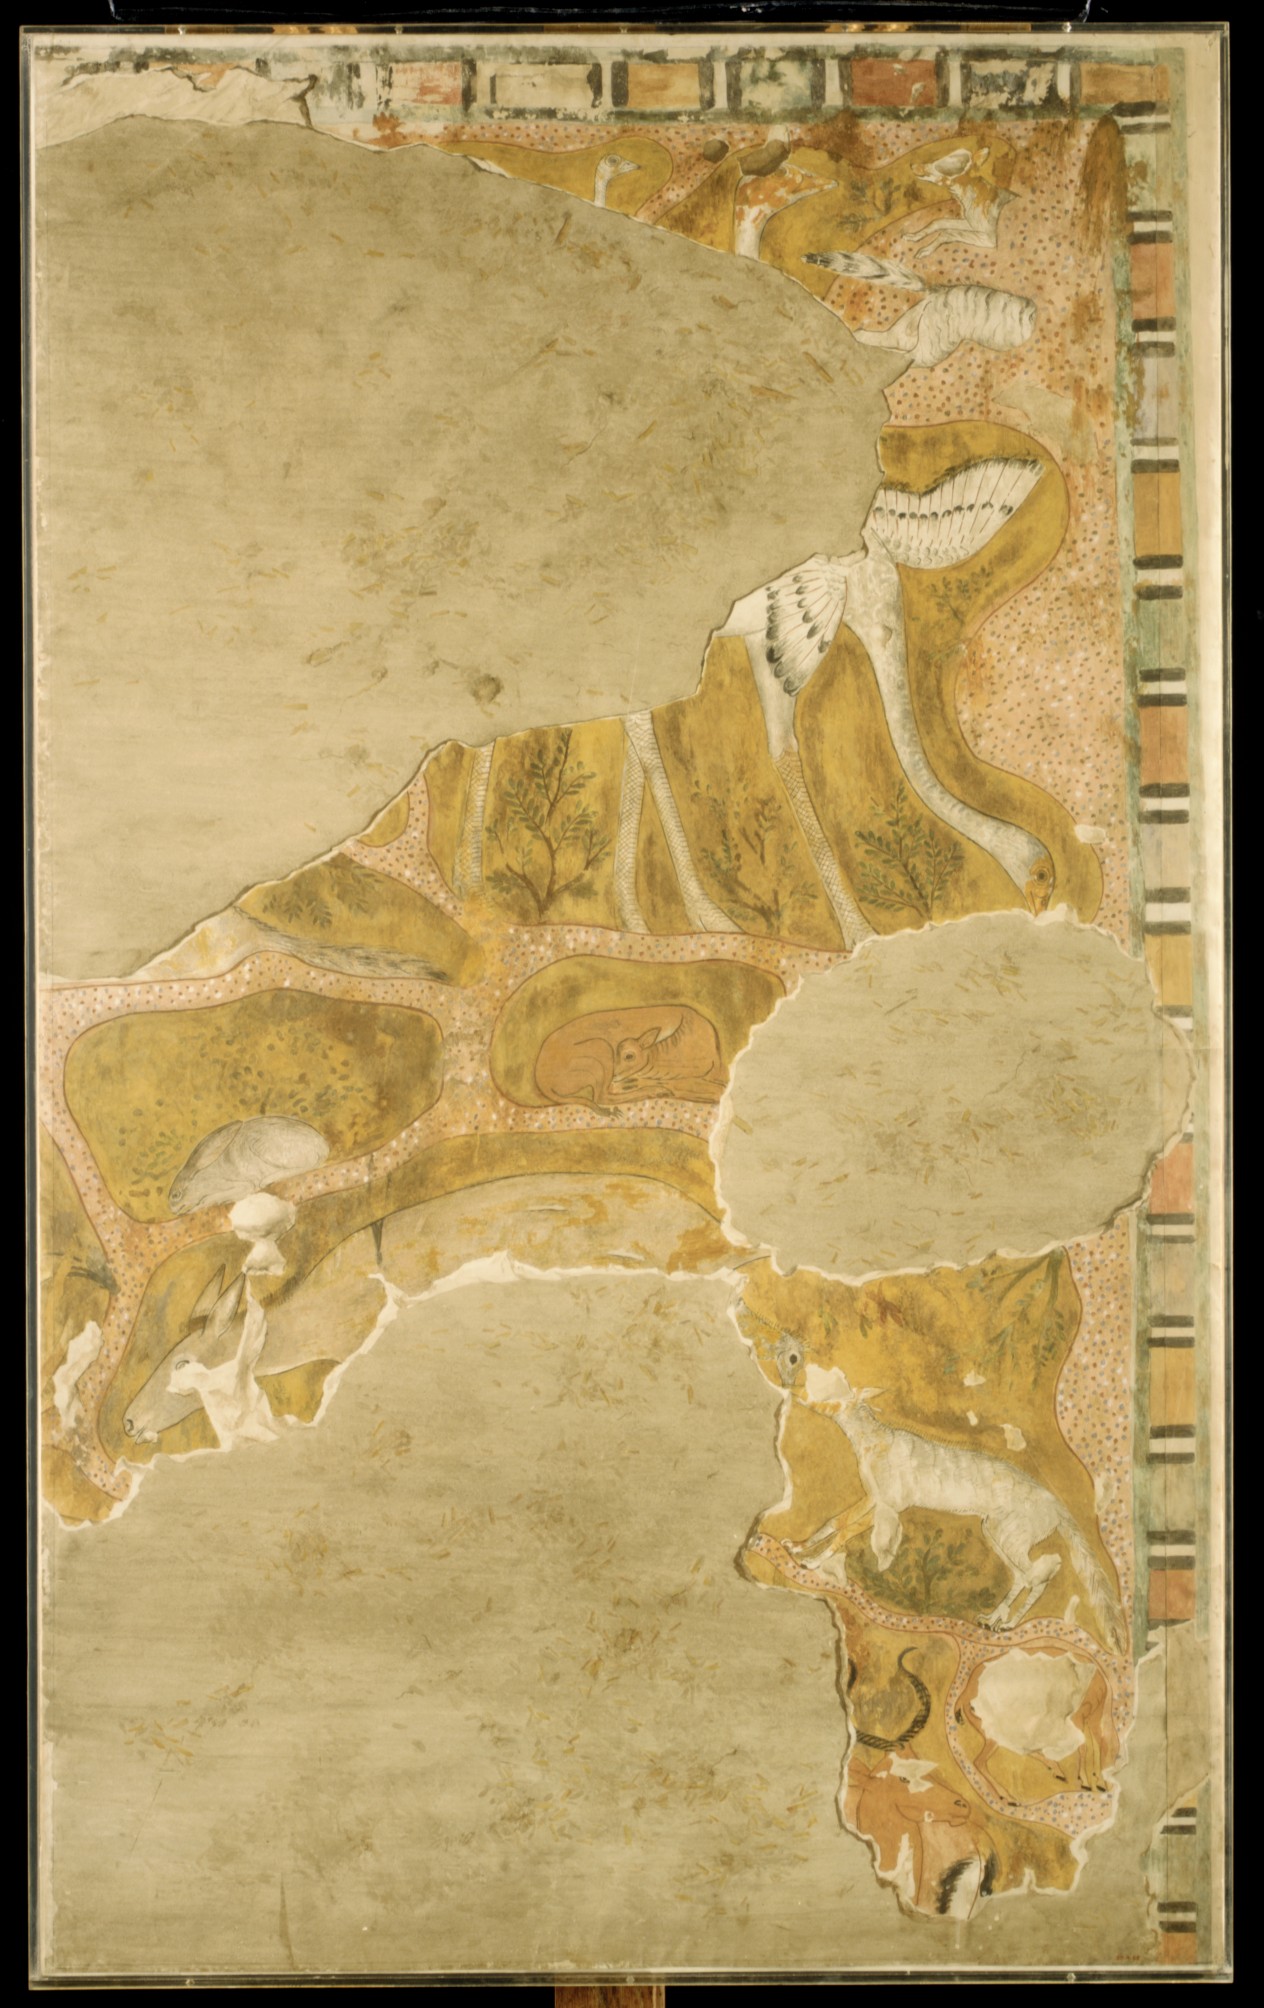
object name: facsimile, qenamun tt 93, hunting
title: Desert Hunting Scene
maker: hugh r. hopgood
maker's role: artist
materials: paper, paint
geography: egypt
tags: animals,birds,hunting,deserts